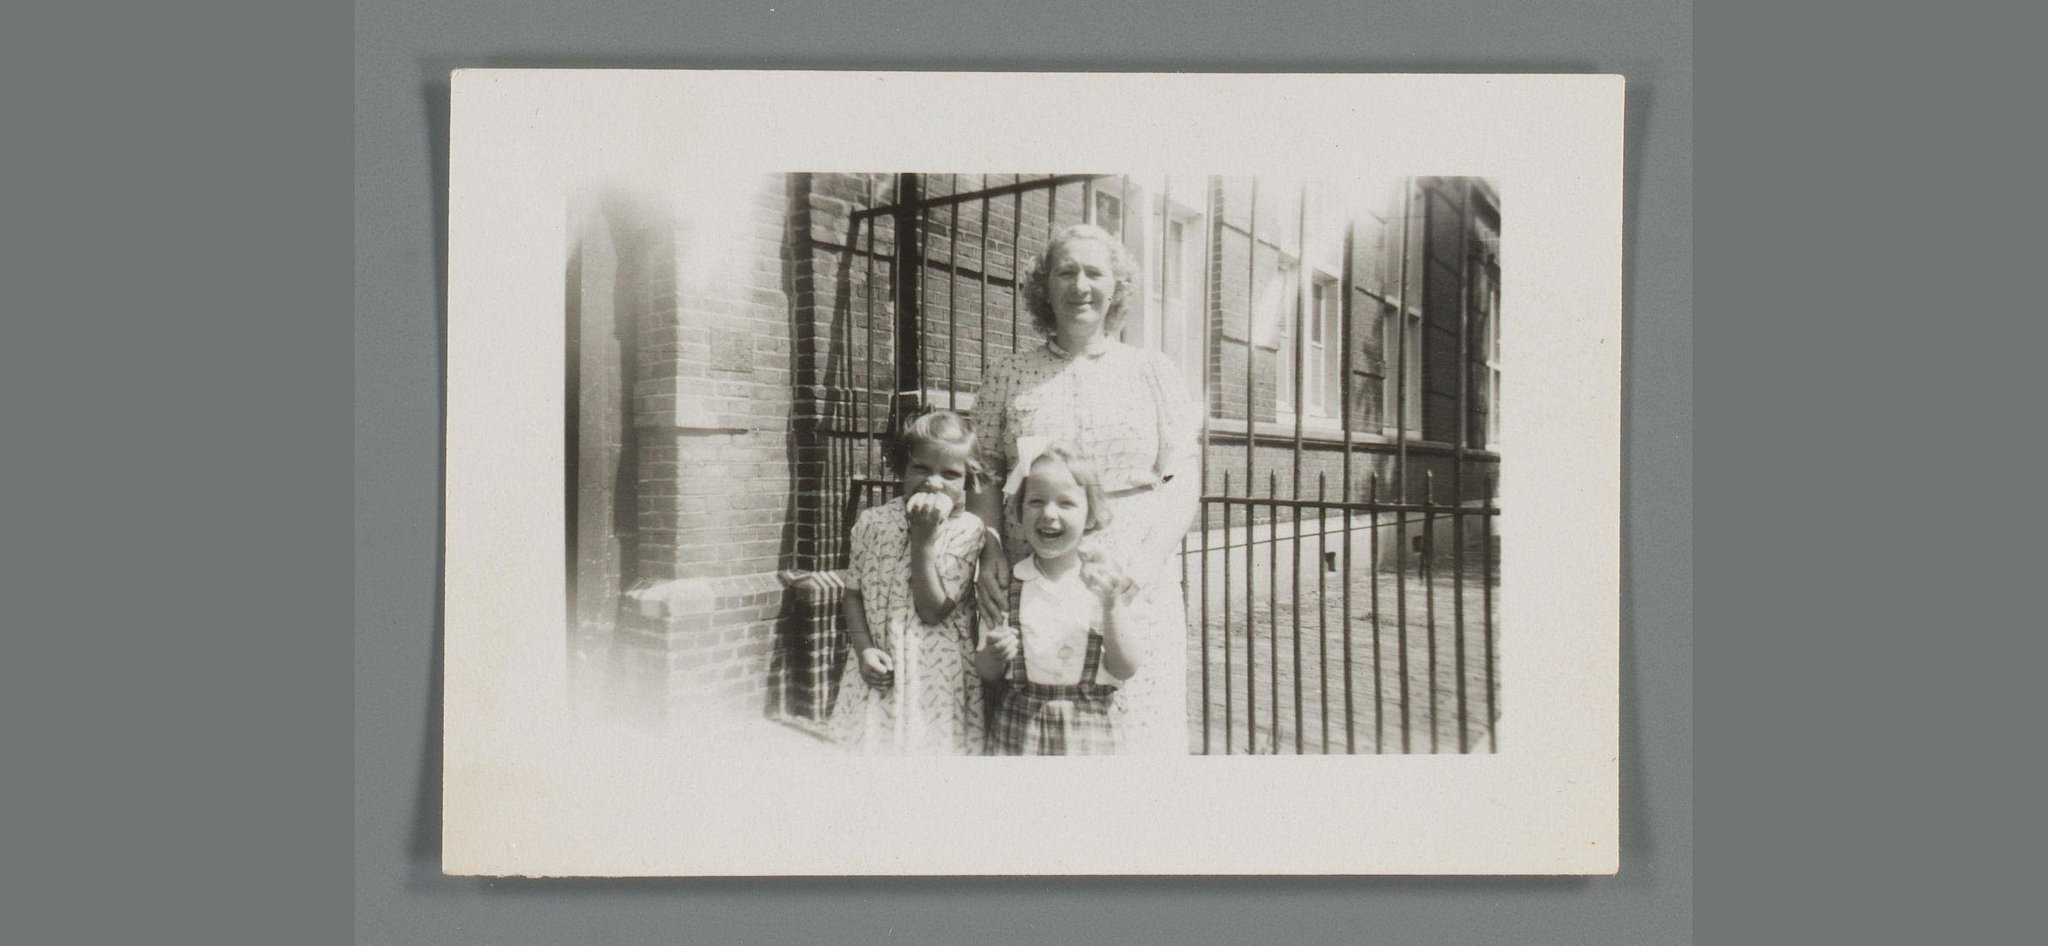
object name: photograph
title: Groepsportret van een onbekende vrouw met twee kinderen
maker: Anonymous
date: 1930-1960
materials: paper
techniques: gelatin silver print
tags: historical persons not known by name - bb - woman, mother and child(ren), woman and child(ren) (family group)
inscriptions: inscription: ‘Sonja/ Fransien/ Tosca/ Ge[?]’